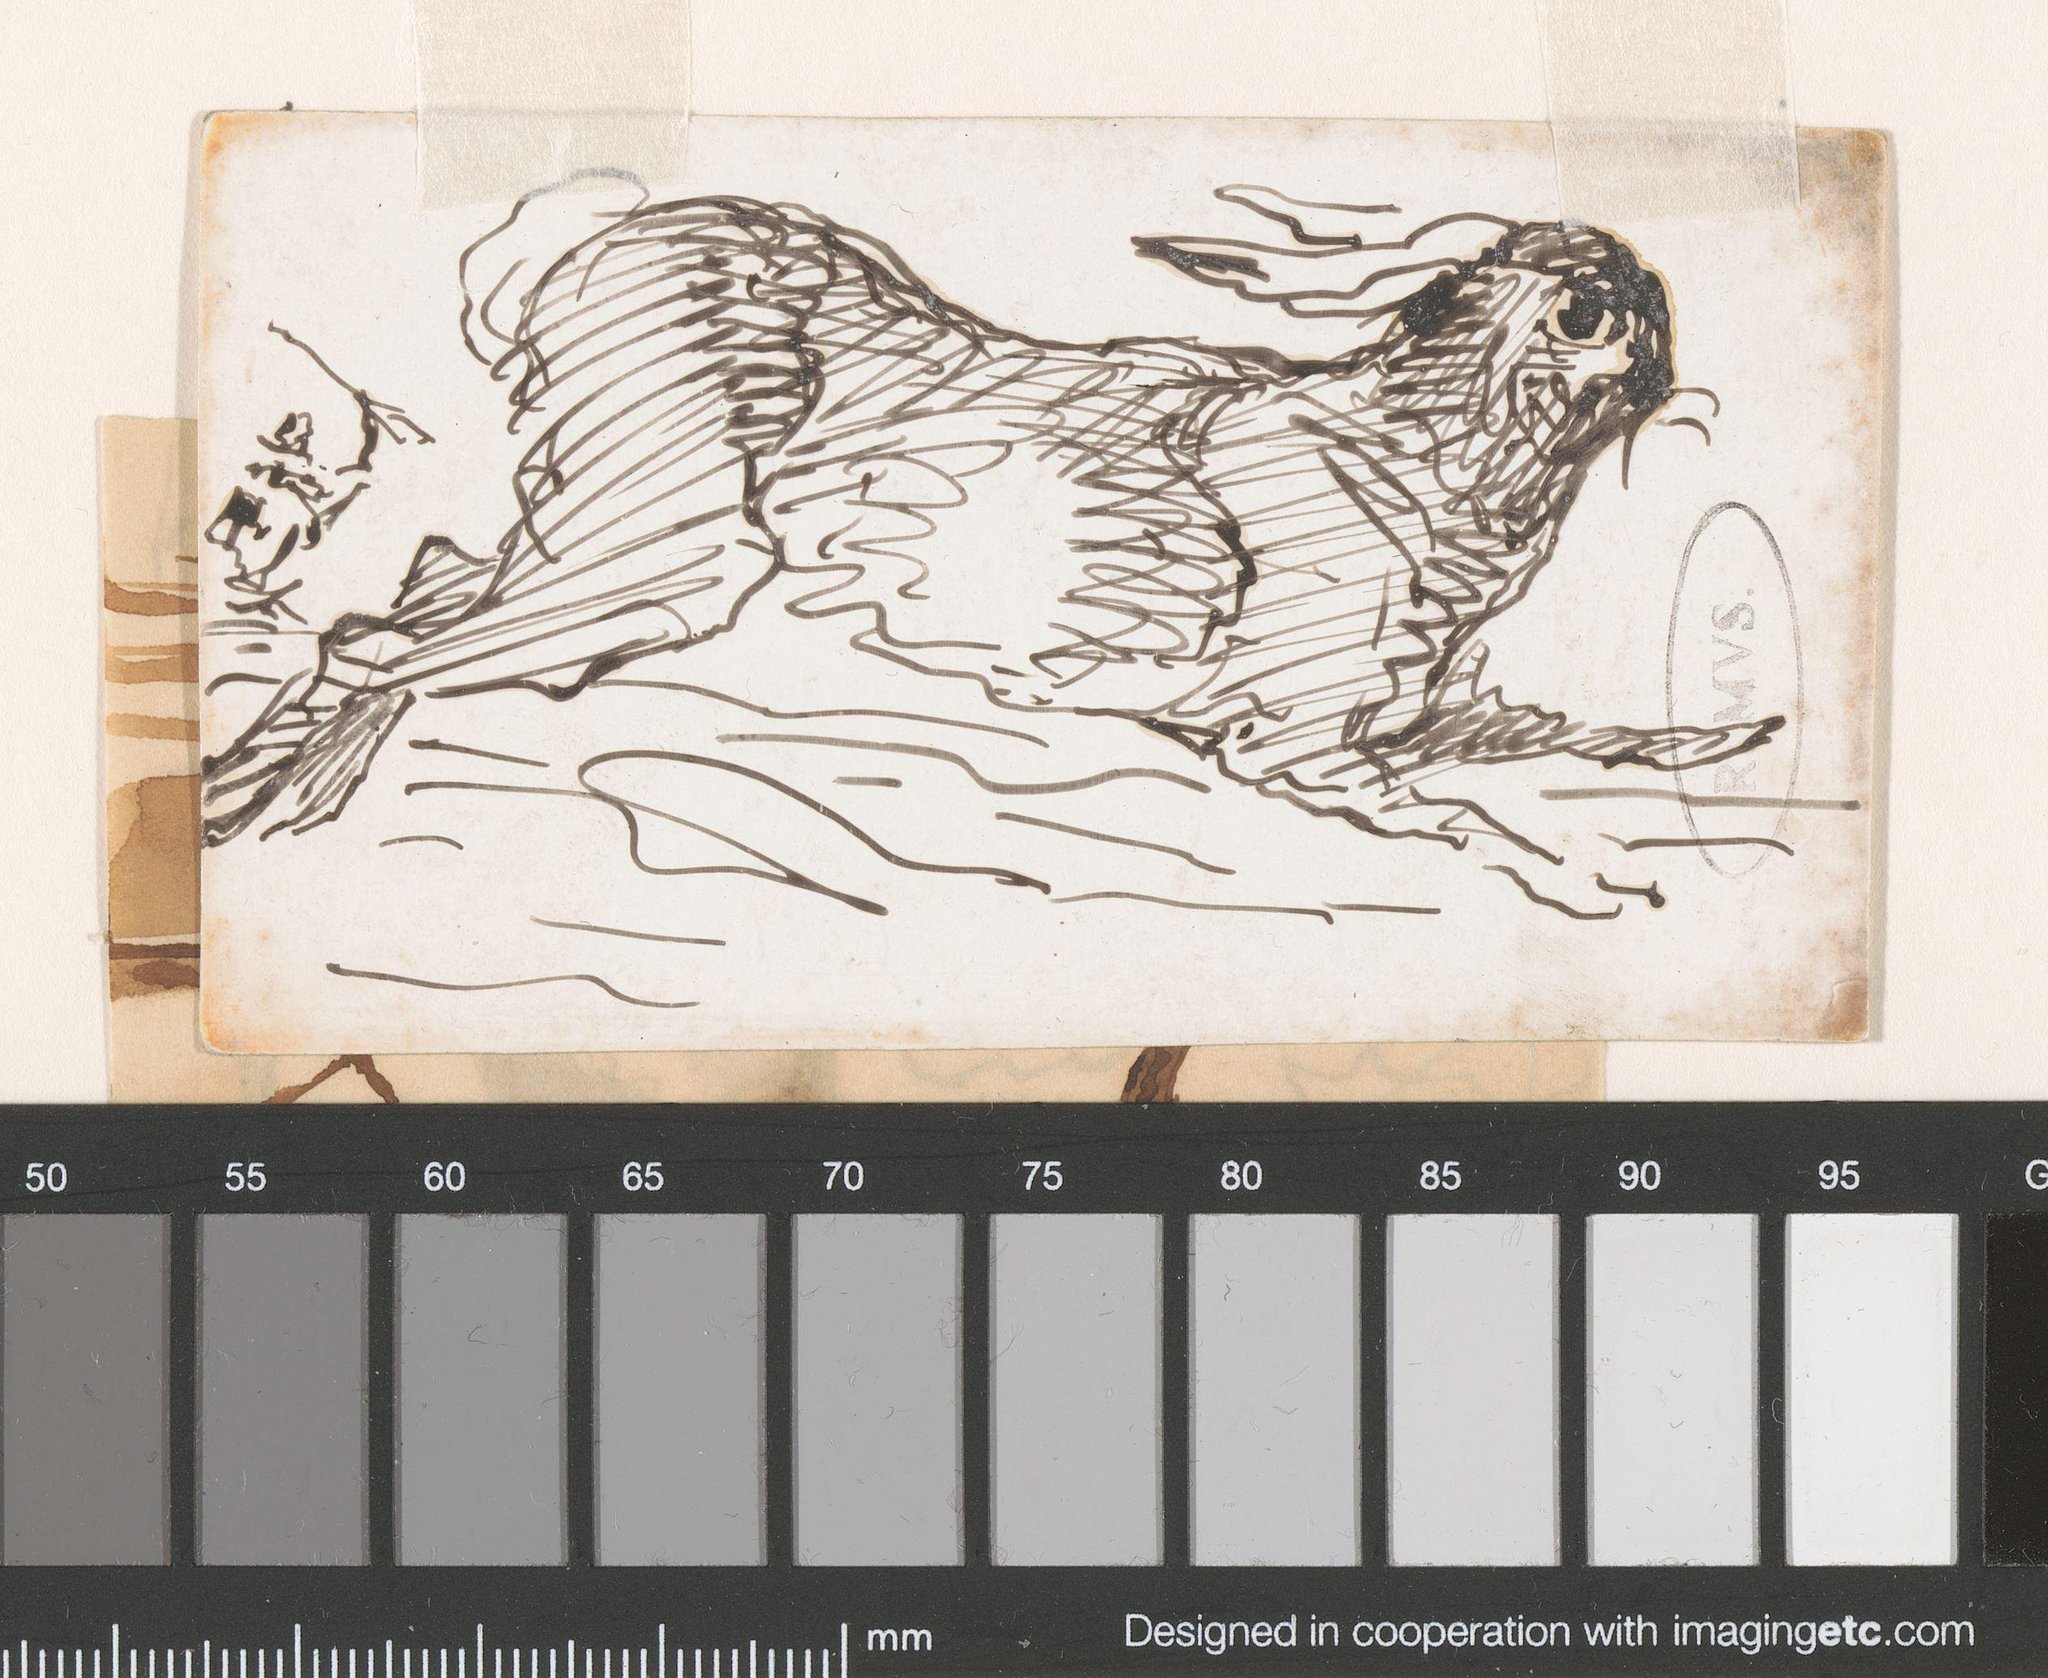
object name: drawing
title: Haas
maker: johannes tavenraat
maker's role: draughtsman, painter, print maker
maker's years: 1809-1881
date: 1870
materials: ink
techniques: pen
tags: rodents: hare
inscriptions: collector's mark: Lugt 2228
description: Haas. Getekend op de achterzijde van een visitekaartje van 'N. Engers.'